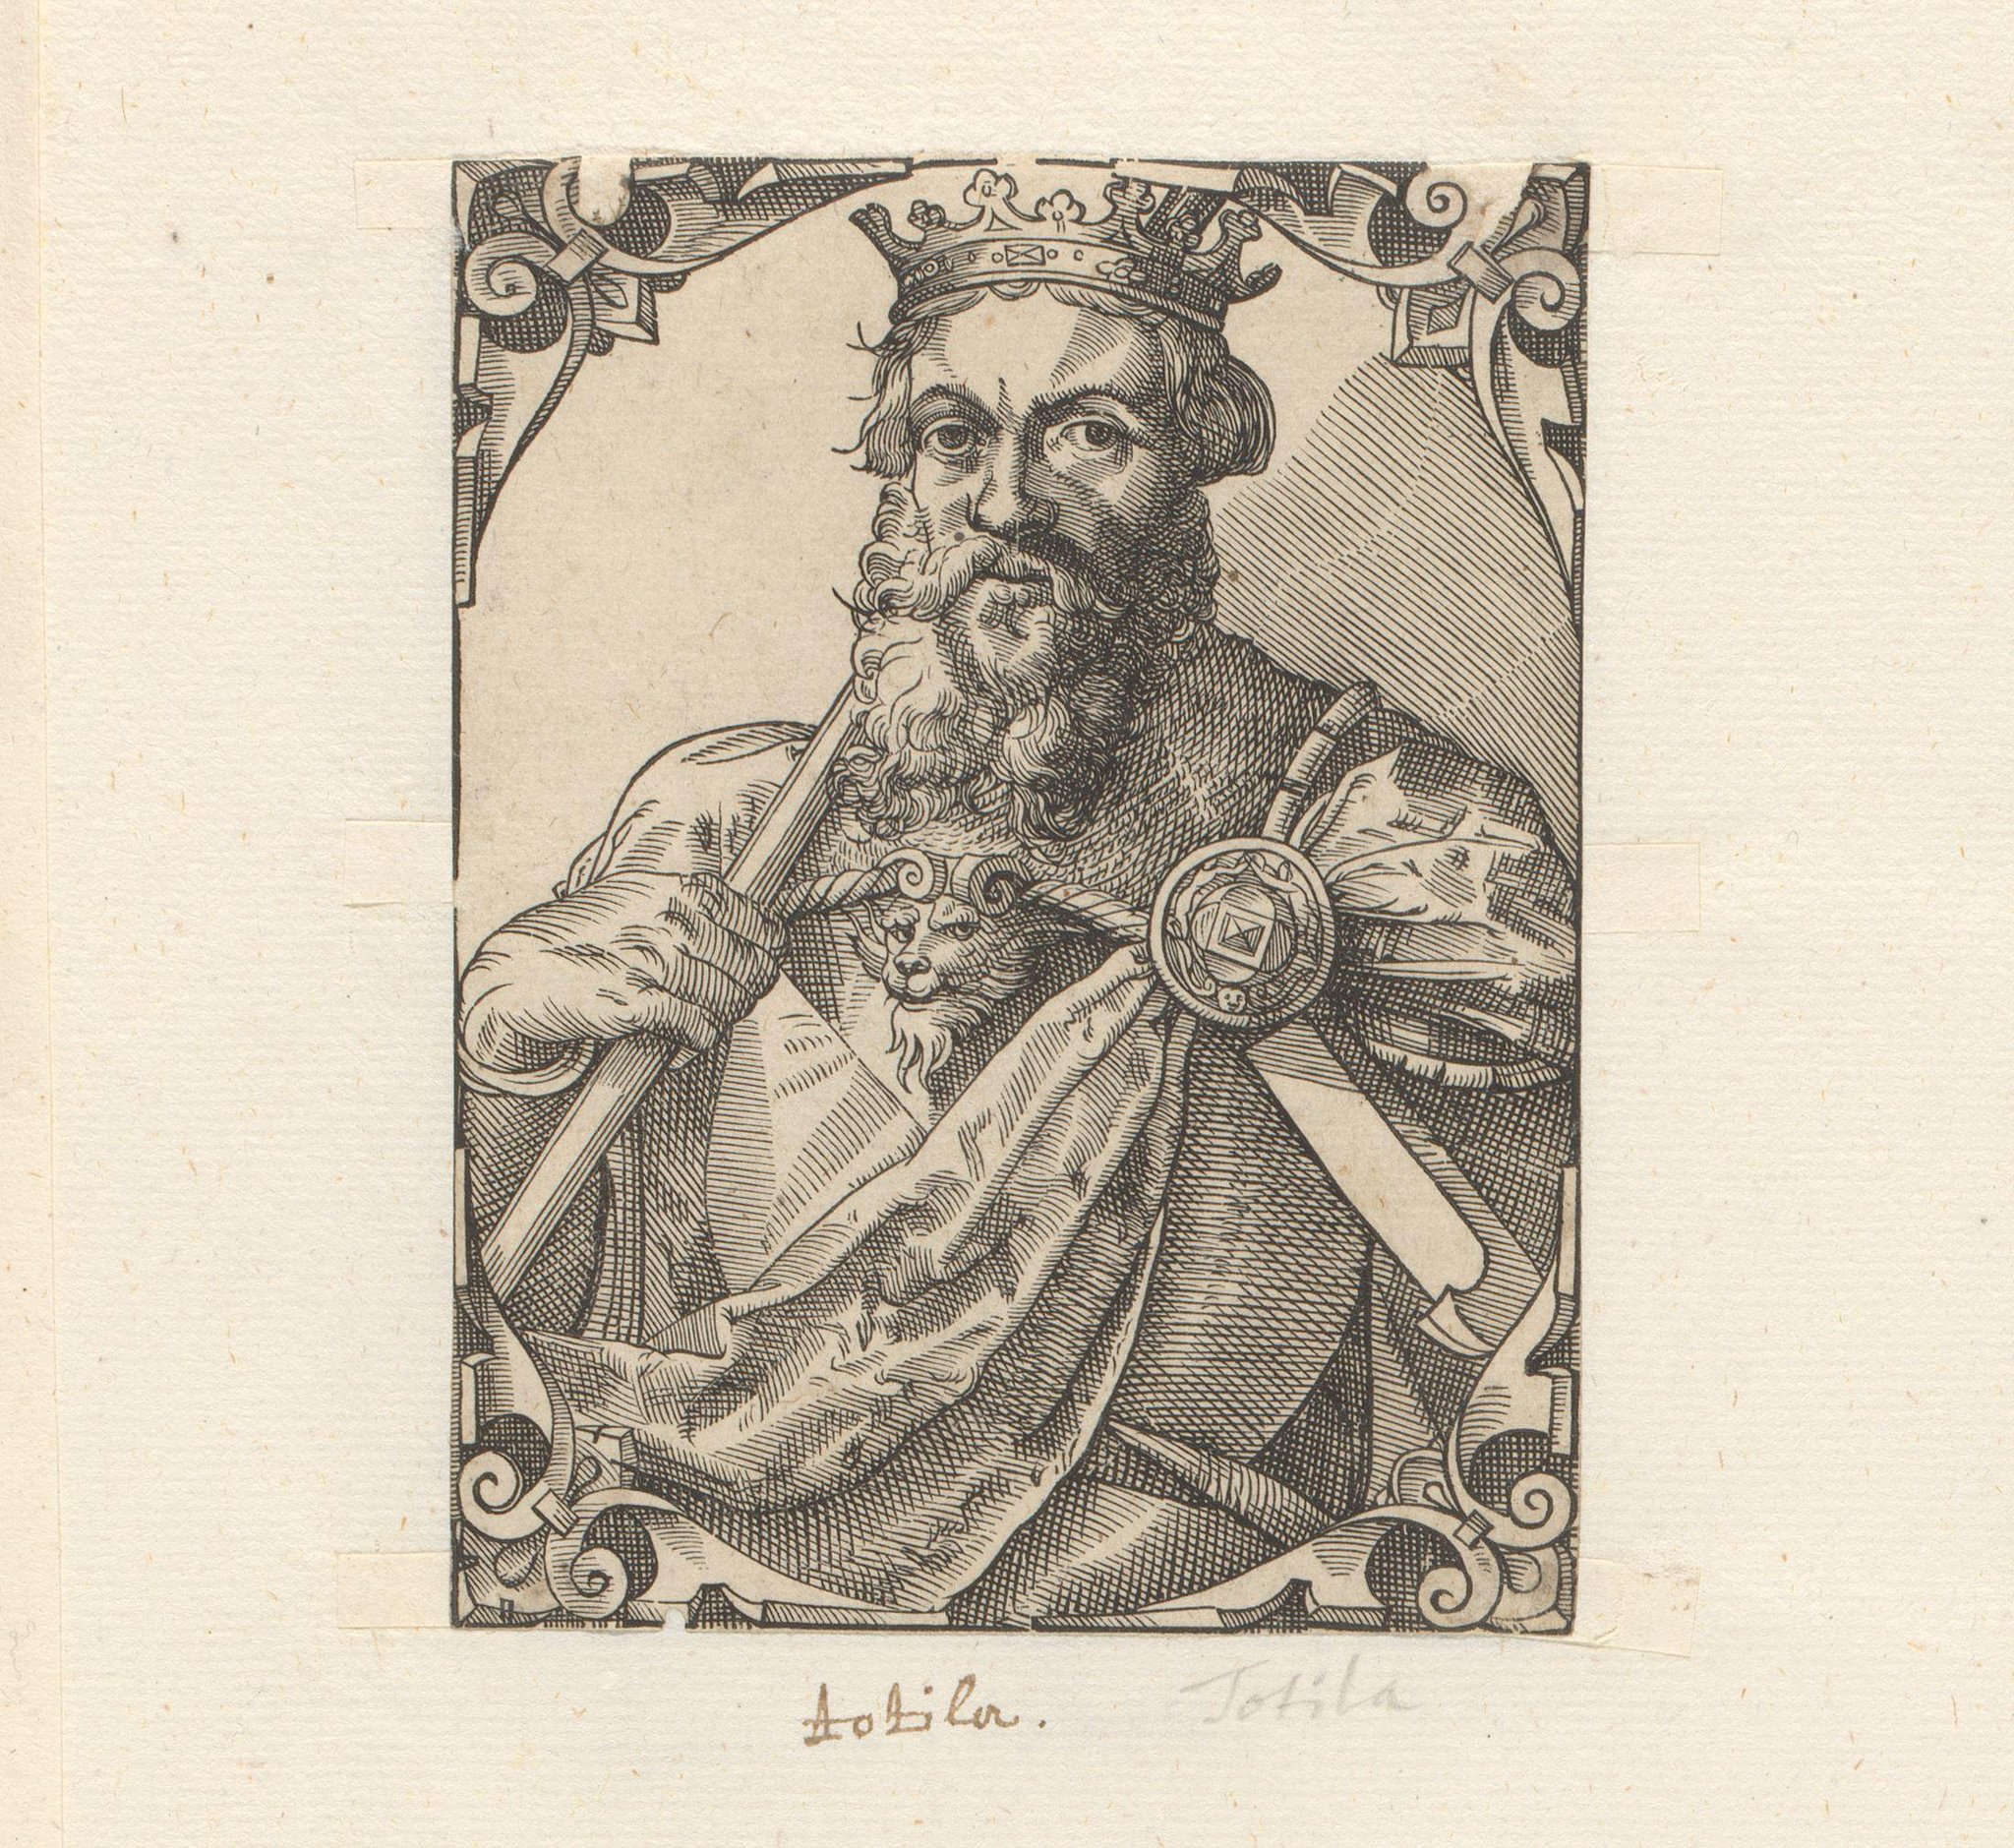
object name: print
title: Portret van Totila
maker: Anonymous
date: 1549-1575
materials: paper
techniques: woodcut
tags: historical persons, king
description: Prent gebruikt in: Giovio, Paolo. Elogia Virorum bellica virtute illustrium (...). Bazel: Peter Perna, 1575.